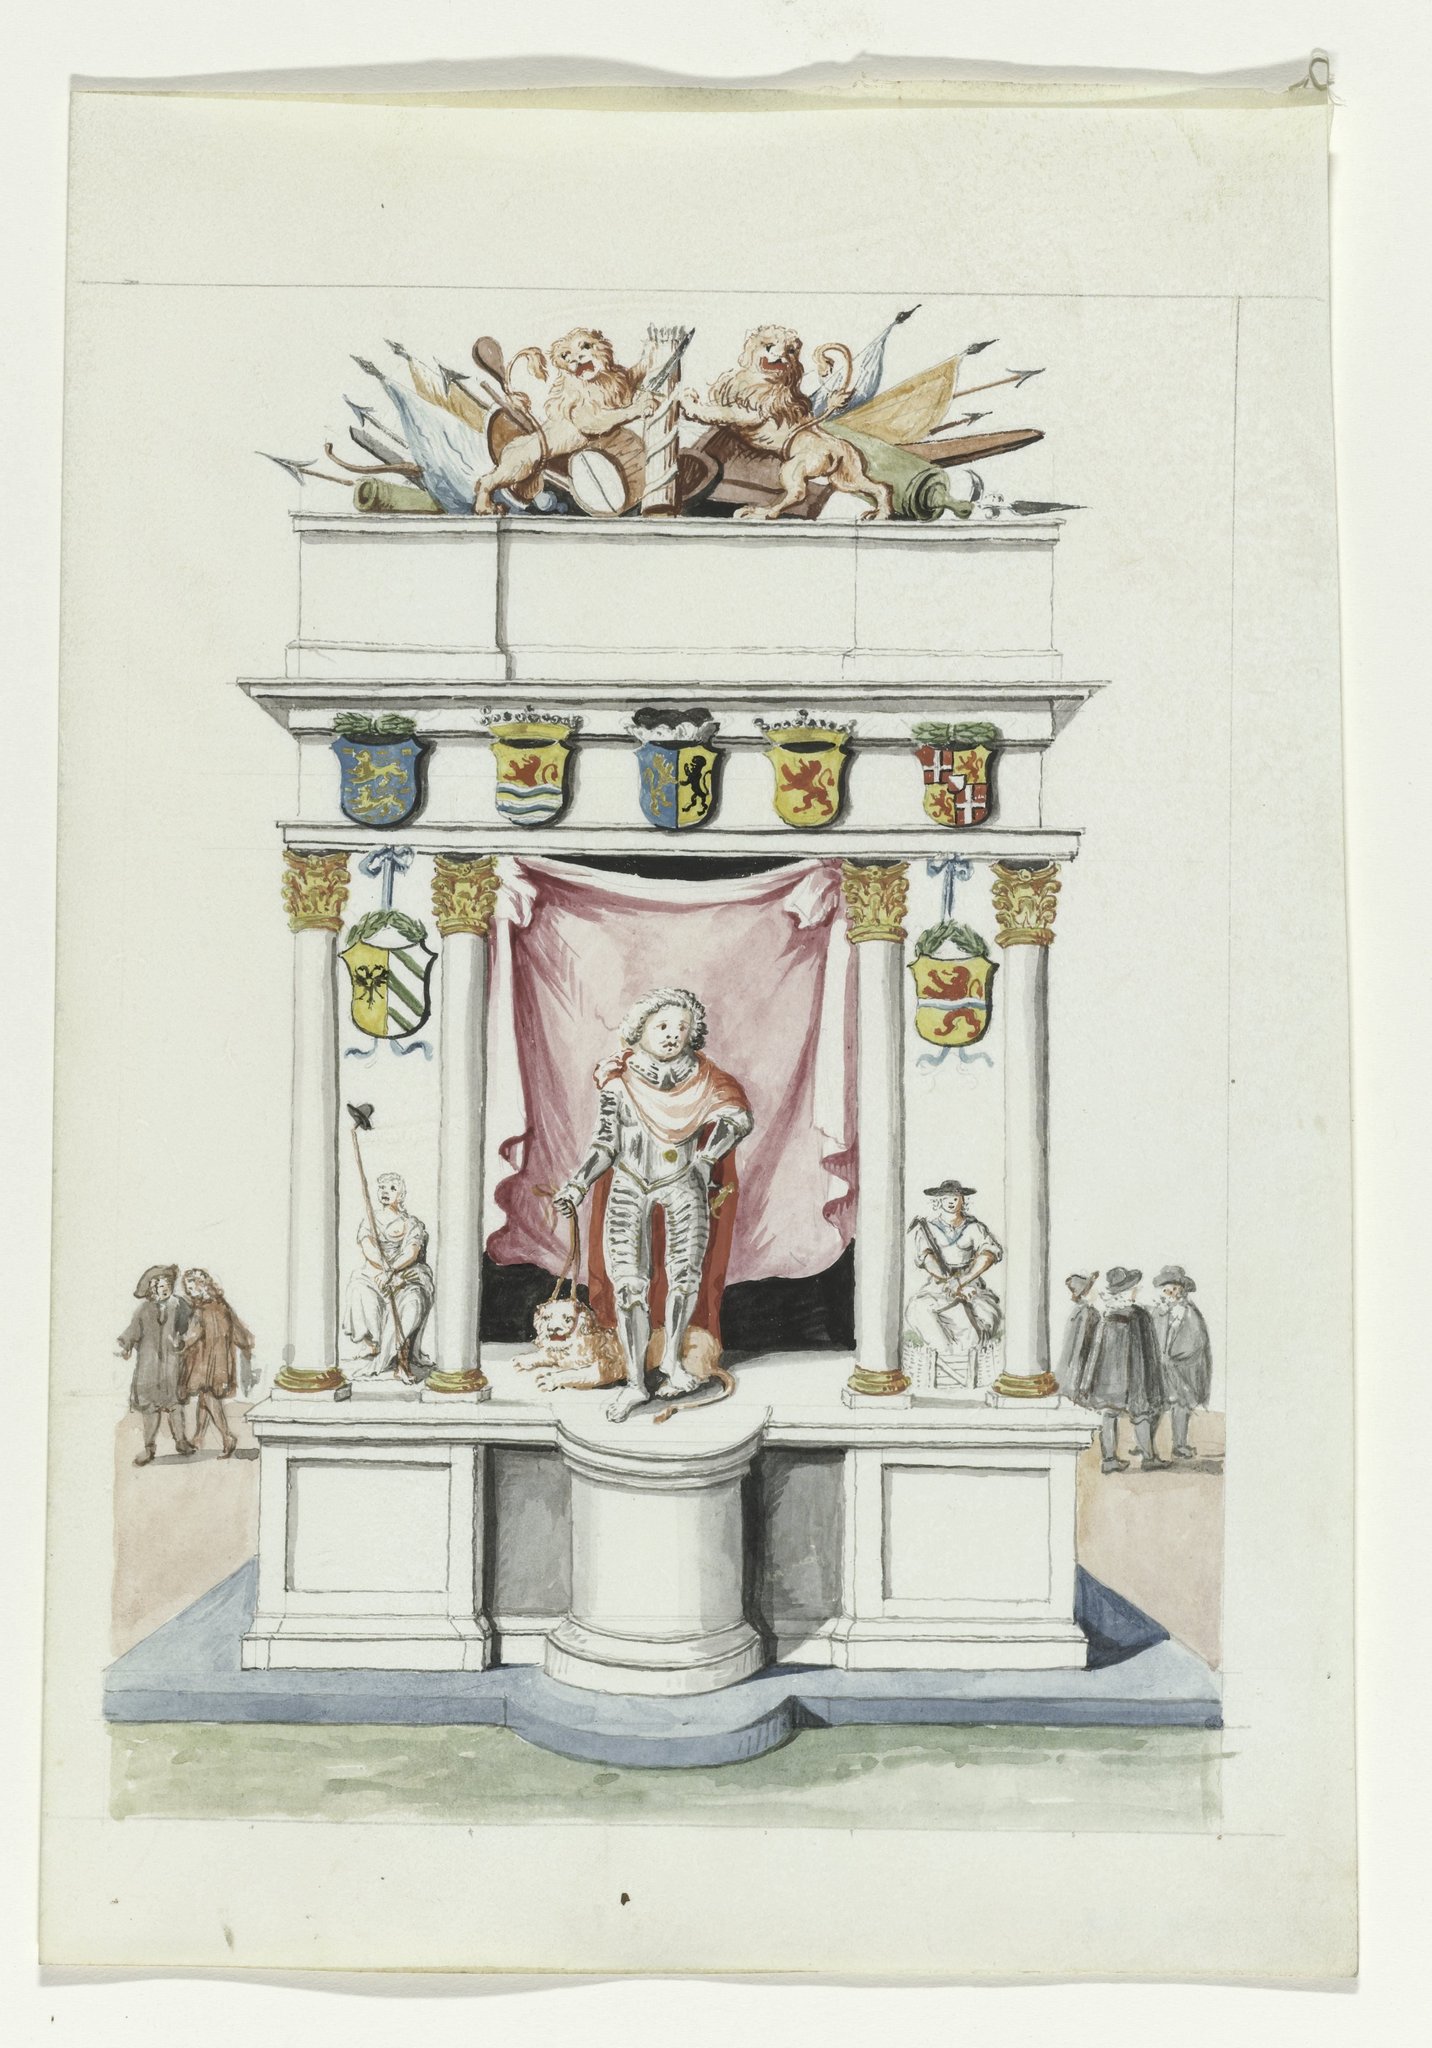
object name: drawing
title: Triomfpoort van prins Maurits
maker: Anonymous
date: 1710-1720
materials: ink, parchment, watercolor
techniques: brush, pen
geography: netherlands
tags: johan van oldenbarnevelt, the hague, maurice (prince of orange), triumphal arch, political caricatures and satires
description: Aquarel waarop triomfpoort met wapens. Bovenop twee leeuwen met pijlenbundels. Midden op monument prins Maurits in wapenuitrusting met aan een halsband een leeuw. Bijbehorend een handgeschreven tekst. Behorende bij serie aquarellen in boek.